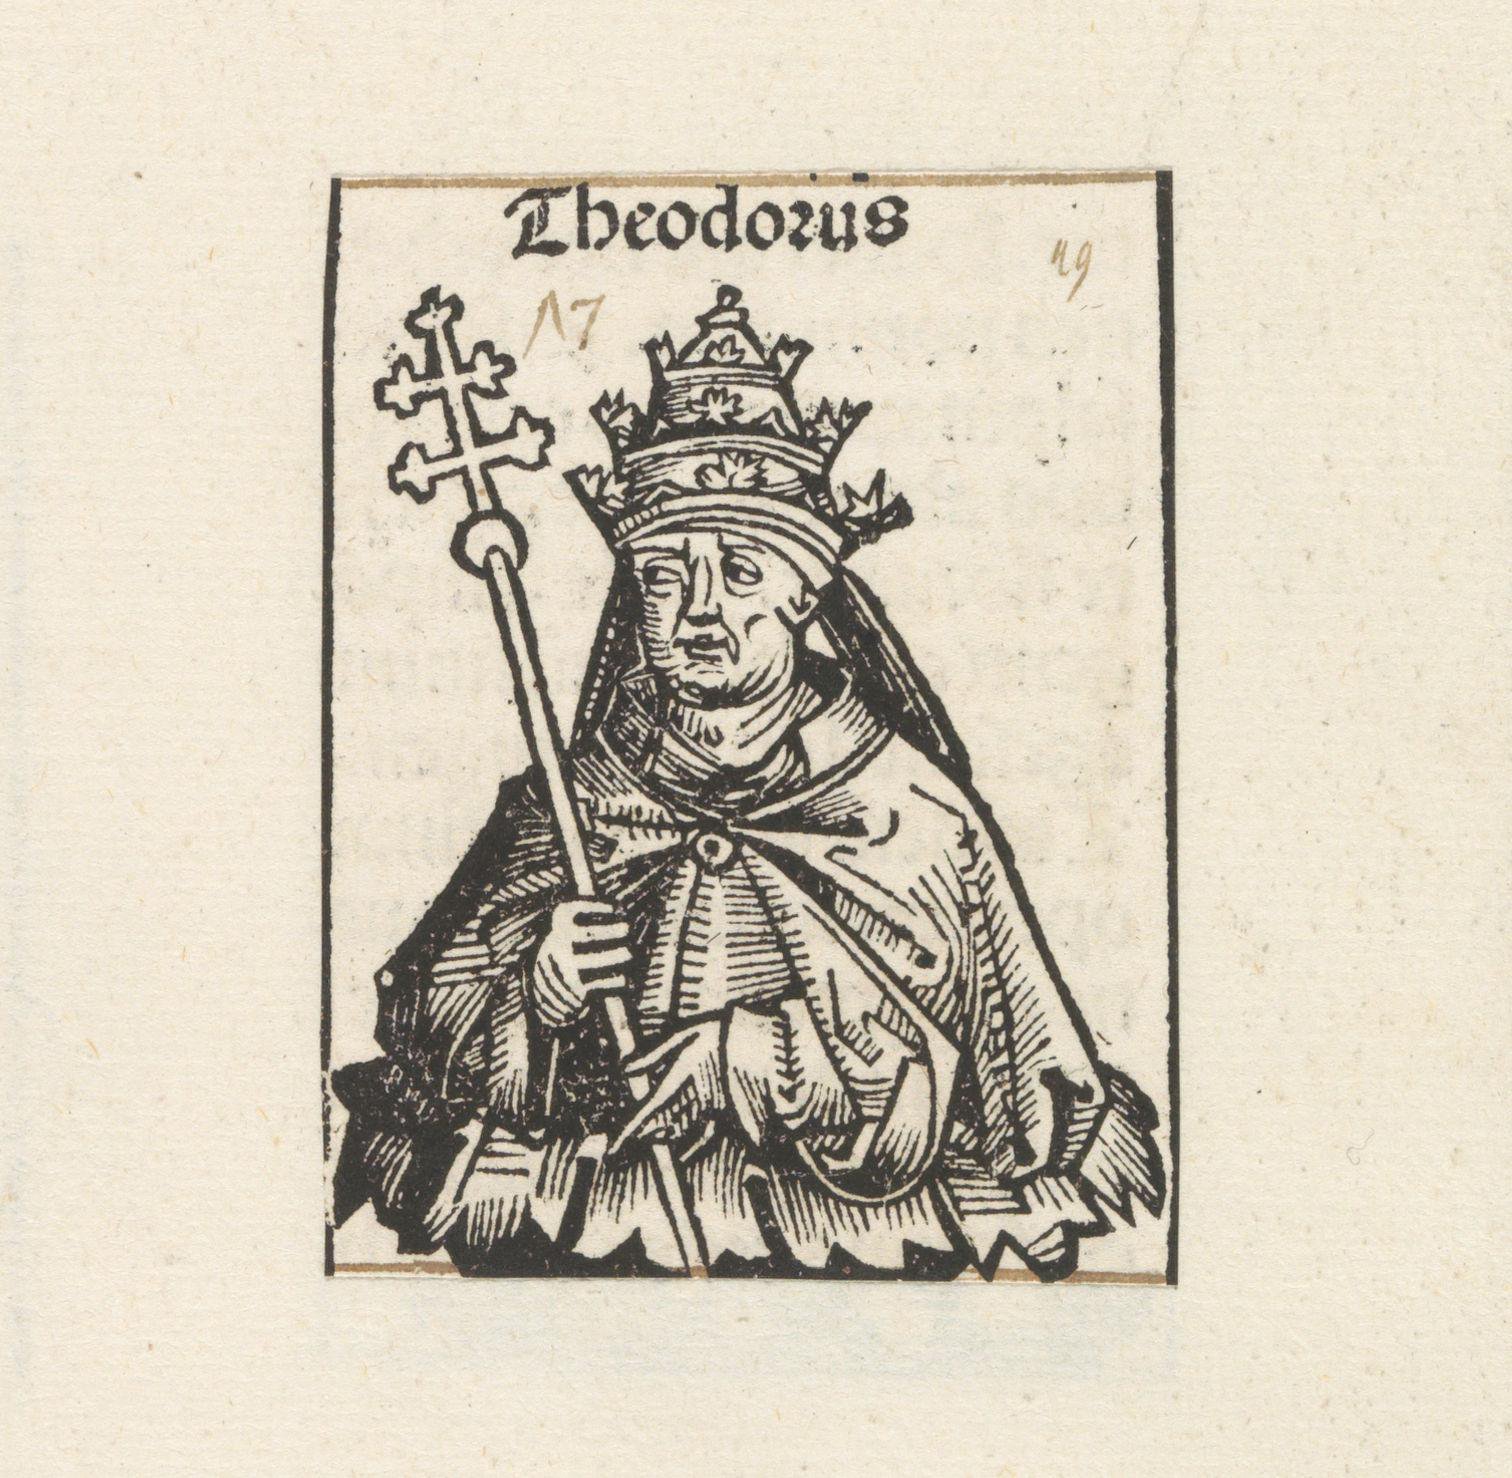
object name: book illustration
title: Liber Chronicarum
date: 1493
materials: paper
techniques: letterpress printing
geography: nuremberg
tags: pope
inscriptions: inscription: ‘49’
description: Een bloemkelk met een paus. Hij draagt een tiara en heeft een staf met een dubbel kruis in zijn handen. De voorstelling is onderdeel van de opeenvolging pausen in de Liber Chronicarum. De tekst identificeert de man als Theodorus I. De prent maakt deel uit van een album.